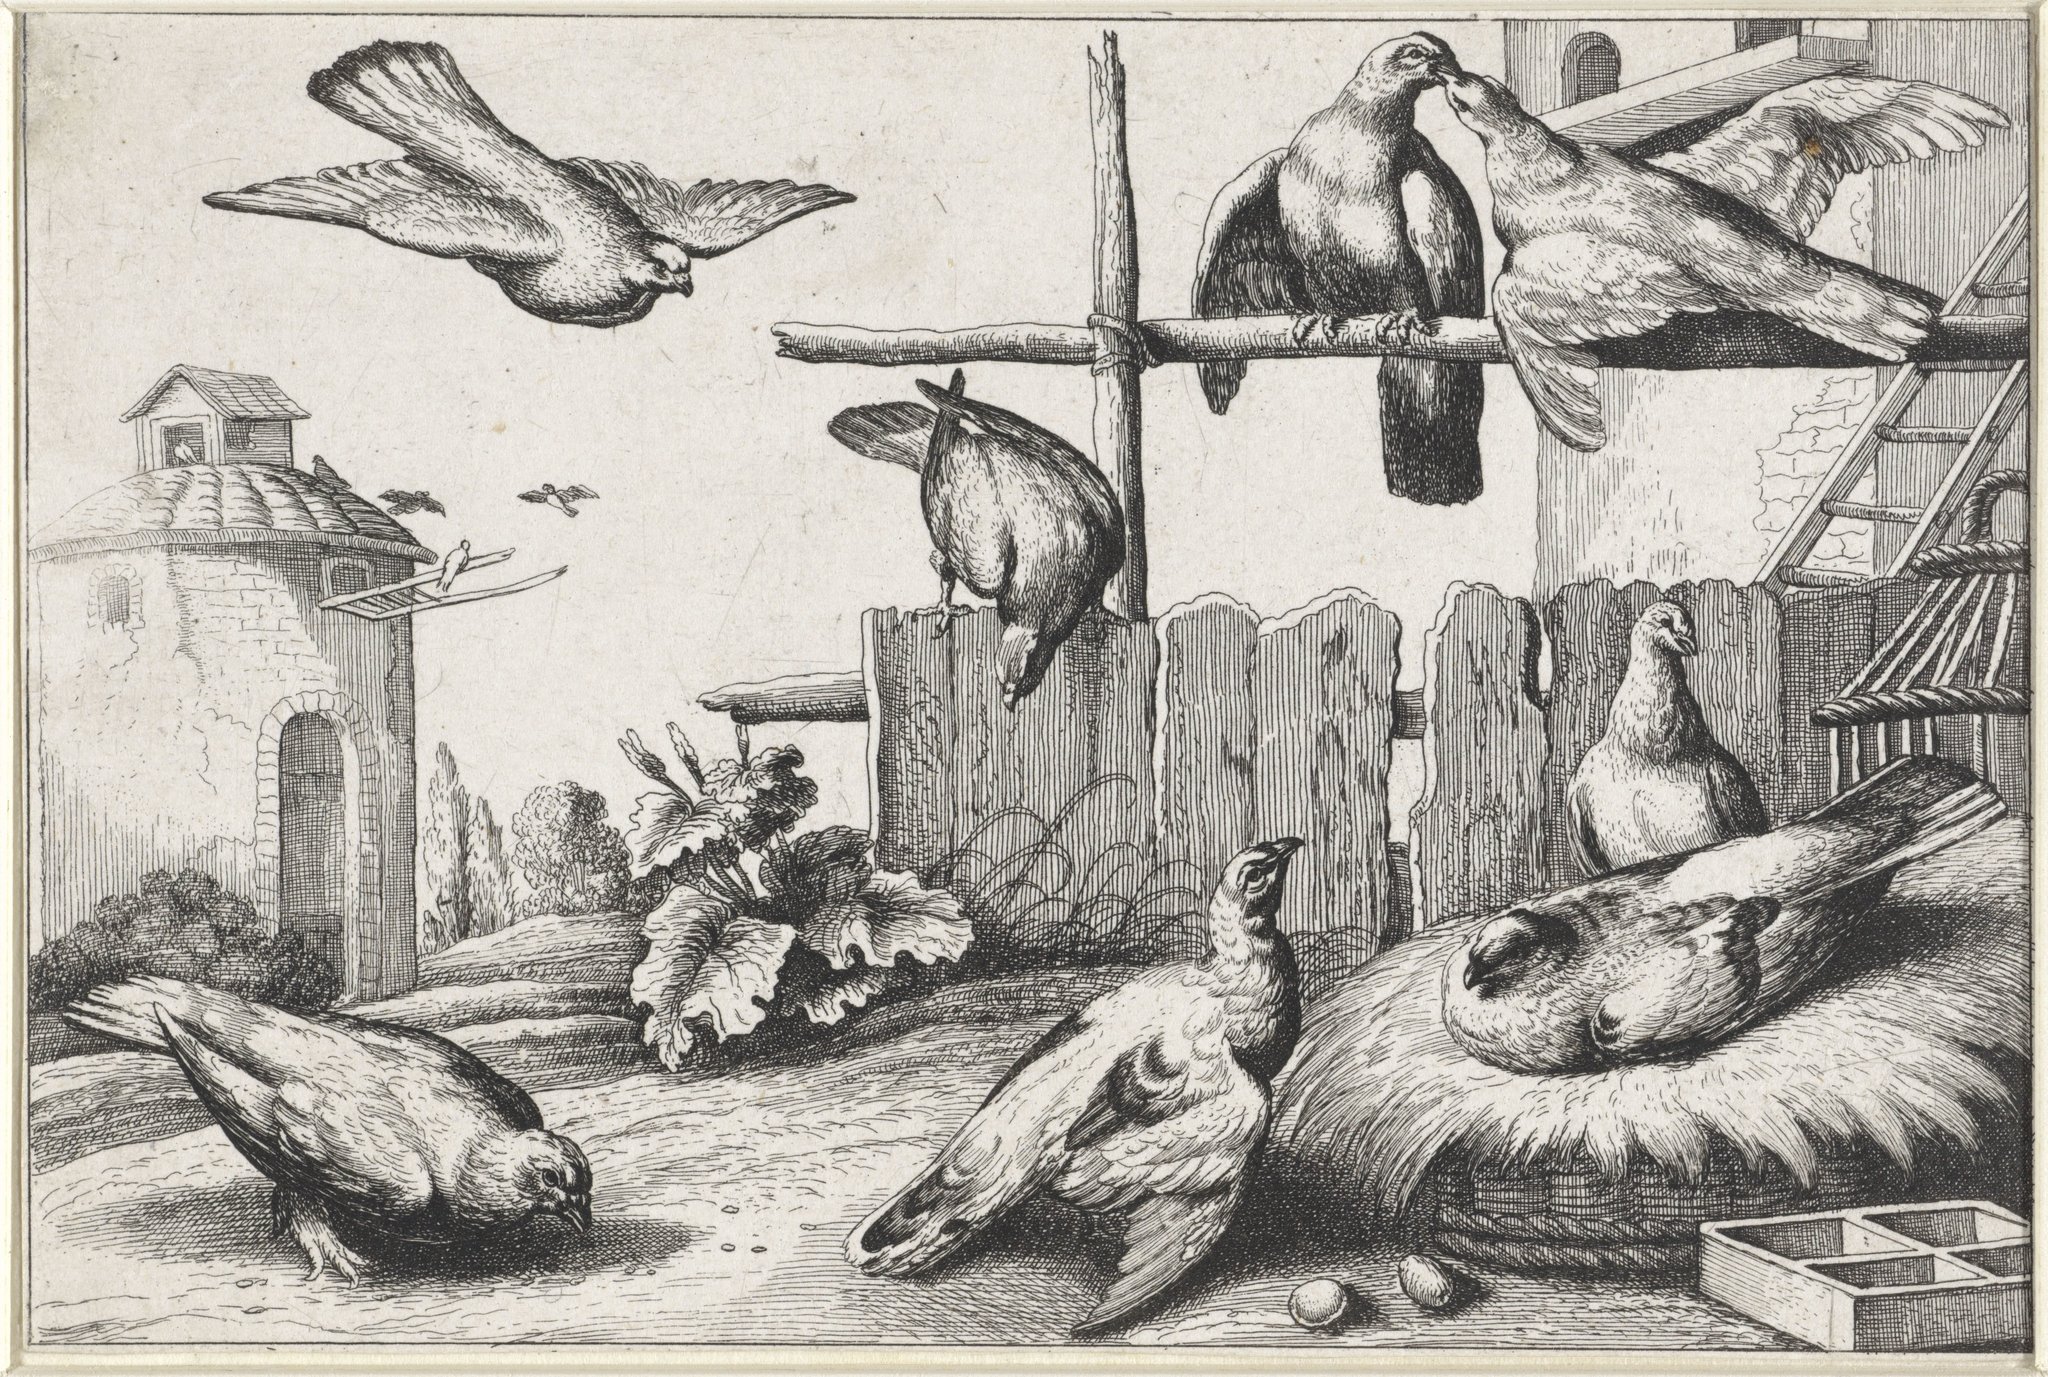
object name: print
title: Duiven bij een duiventil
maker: Anonymous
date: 1654-1712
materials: paper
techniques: etching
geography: england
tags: dove-cote, doves, pigeons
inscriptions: collector's mark: Lugt 240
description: Prent maakt deel uit van de negendelige serie met voorstellingen van verschillende vogels: "Diversae avium species".